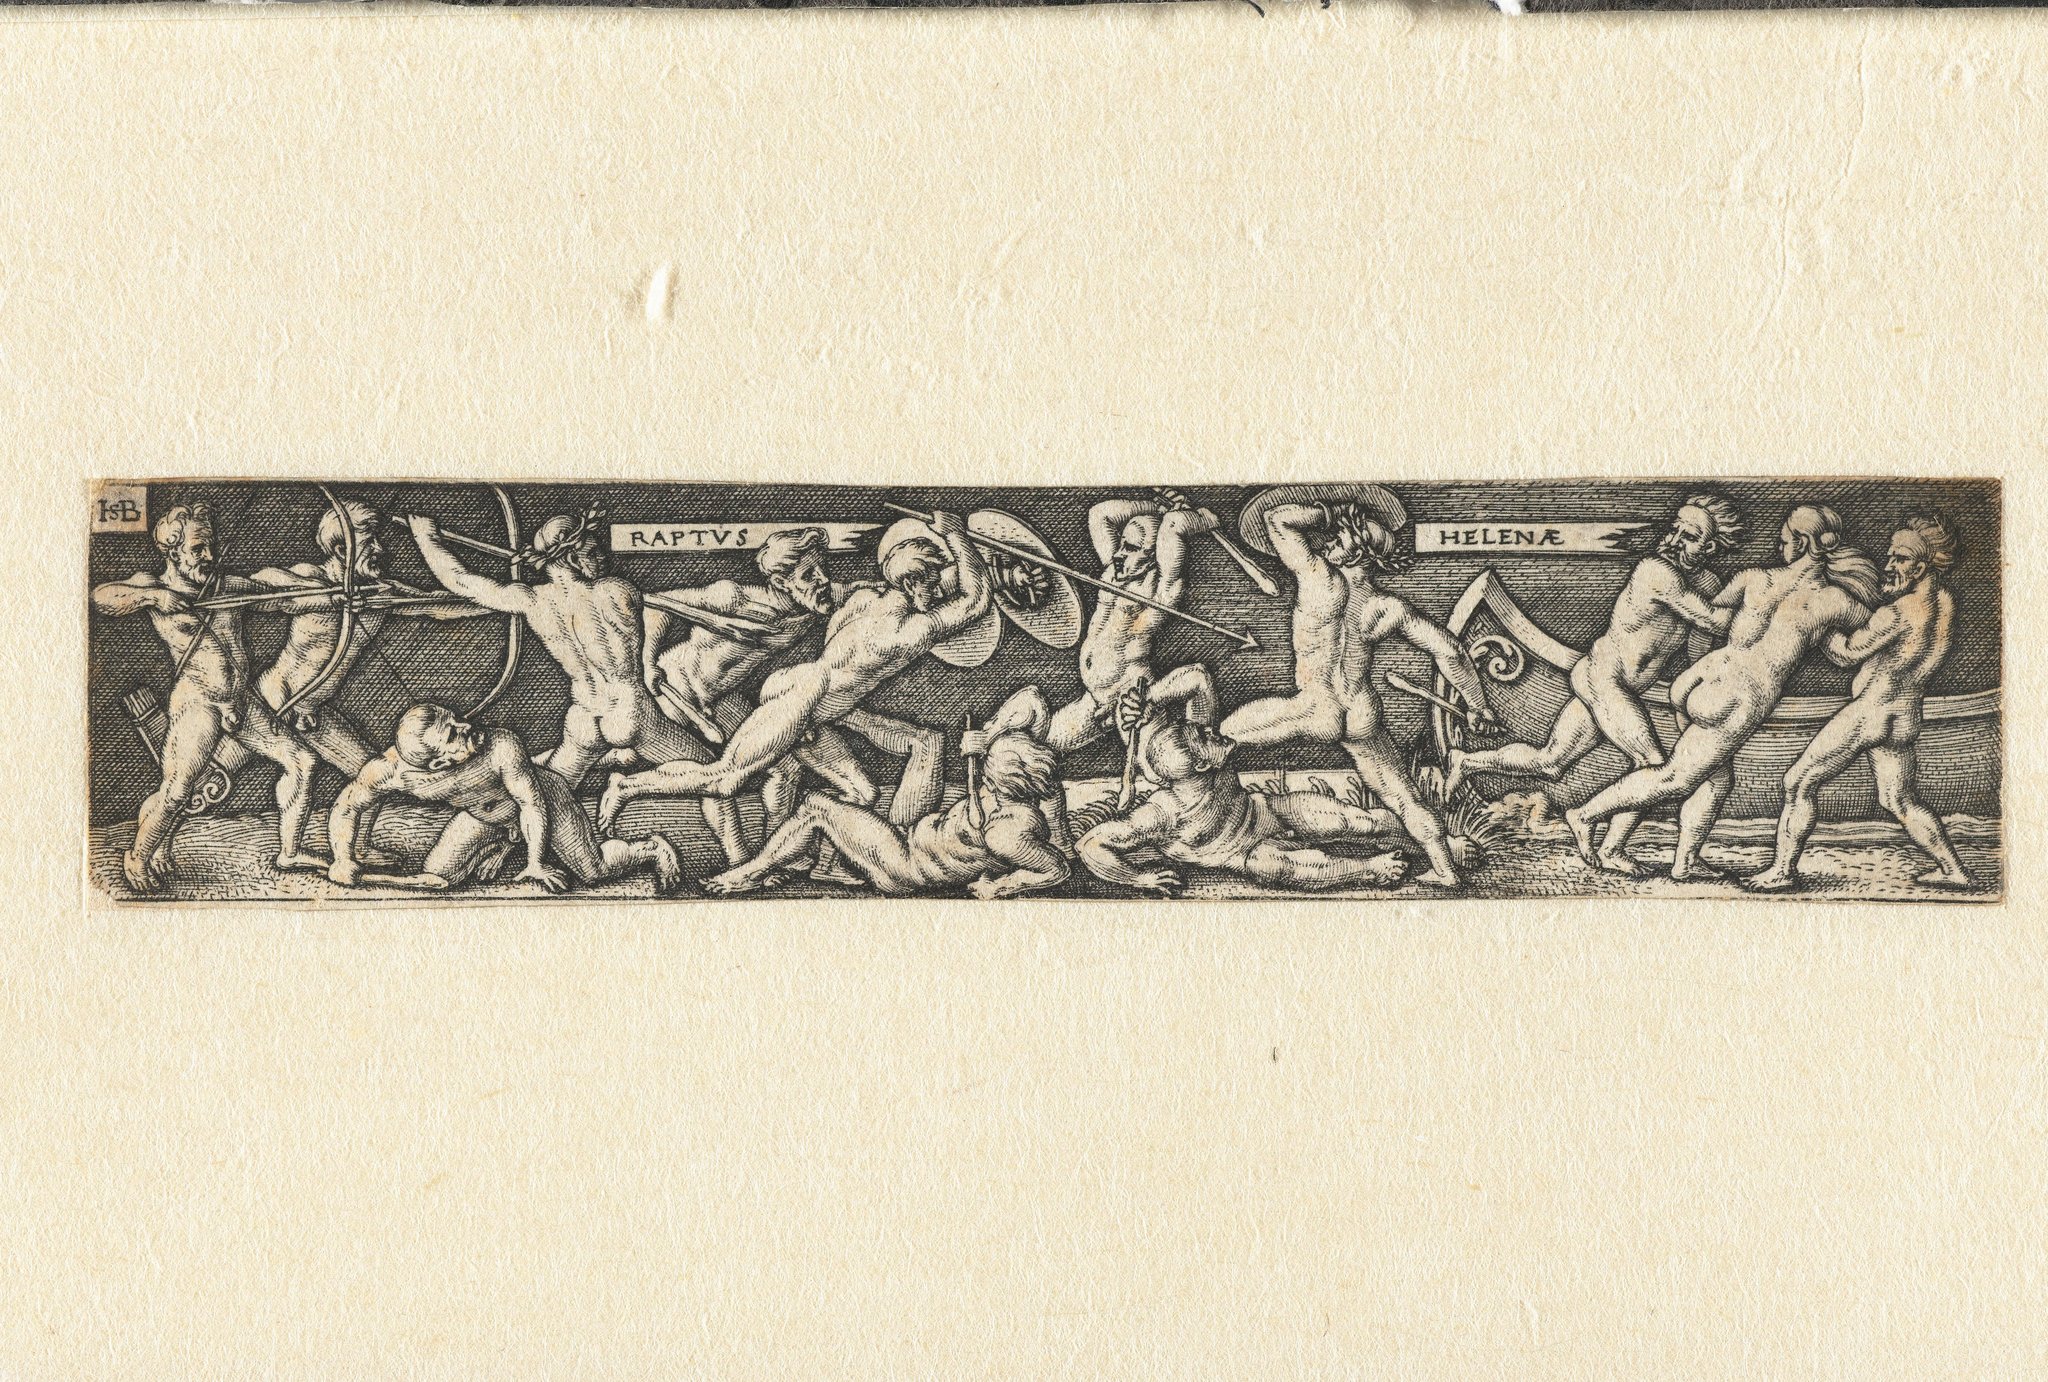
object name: print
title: Raptvs Helenae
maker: hans sebald beham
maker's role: designer, draughtsman, print maker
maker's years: 1500-1550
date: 1510-1550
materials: paper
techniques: engraving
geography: germany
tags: the abduction of helen and some of her companions: paris carries them off by sea, and takes a part of the palace-treasure with him